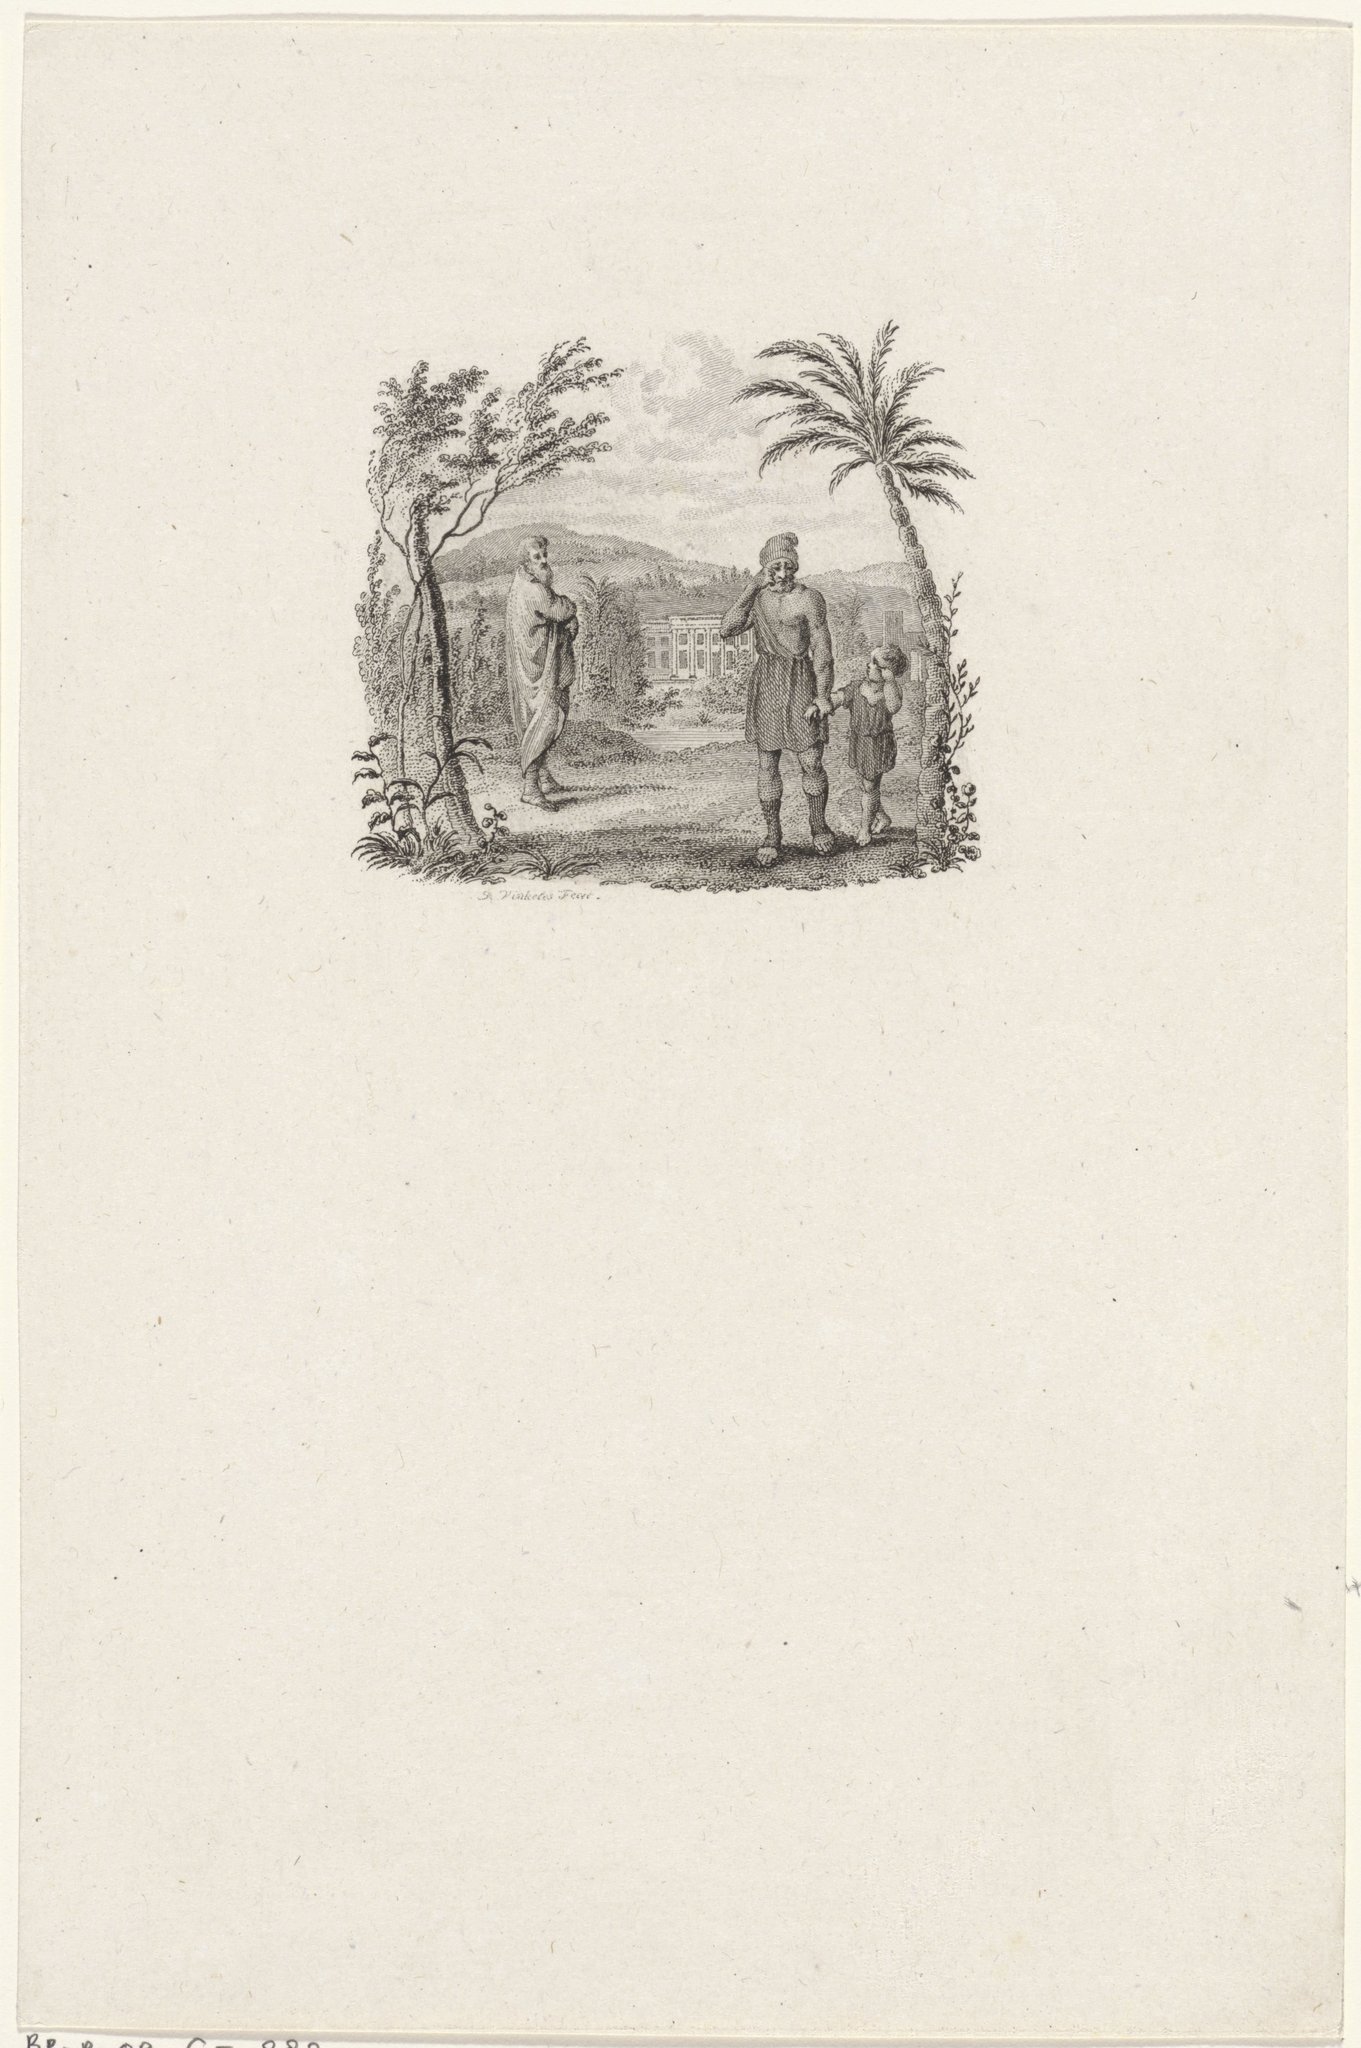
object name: print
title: Man met een kind en een tweede man in een landschap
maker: reinier vinkeles (i)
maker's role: draughtsman, print maker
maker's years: 1741-1816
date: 1751-1816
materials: paper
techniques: engraving, etching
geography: amsterdam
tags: landscapes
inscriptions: collector's mark: Lugt 2228